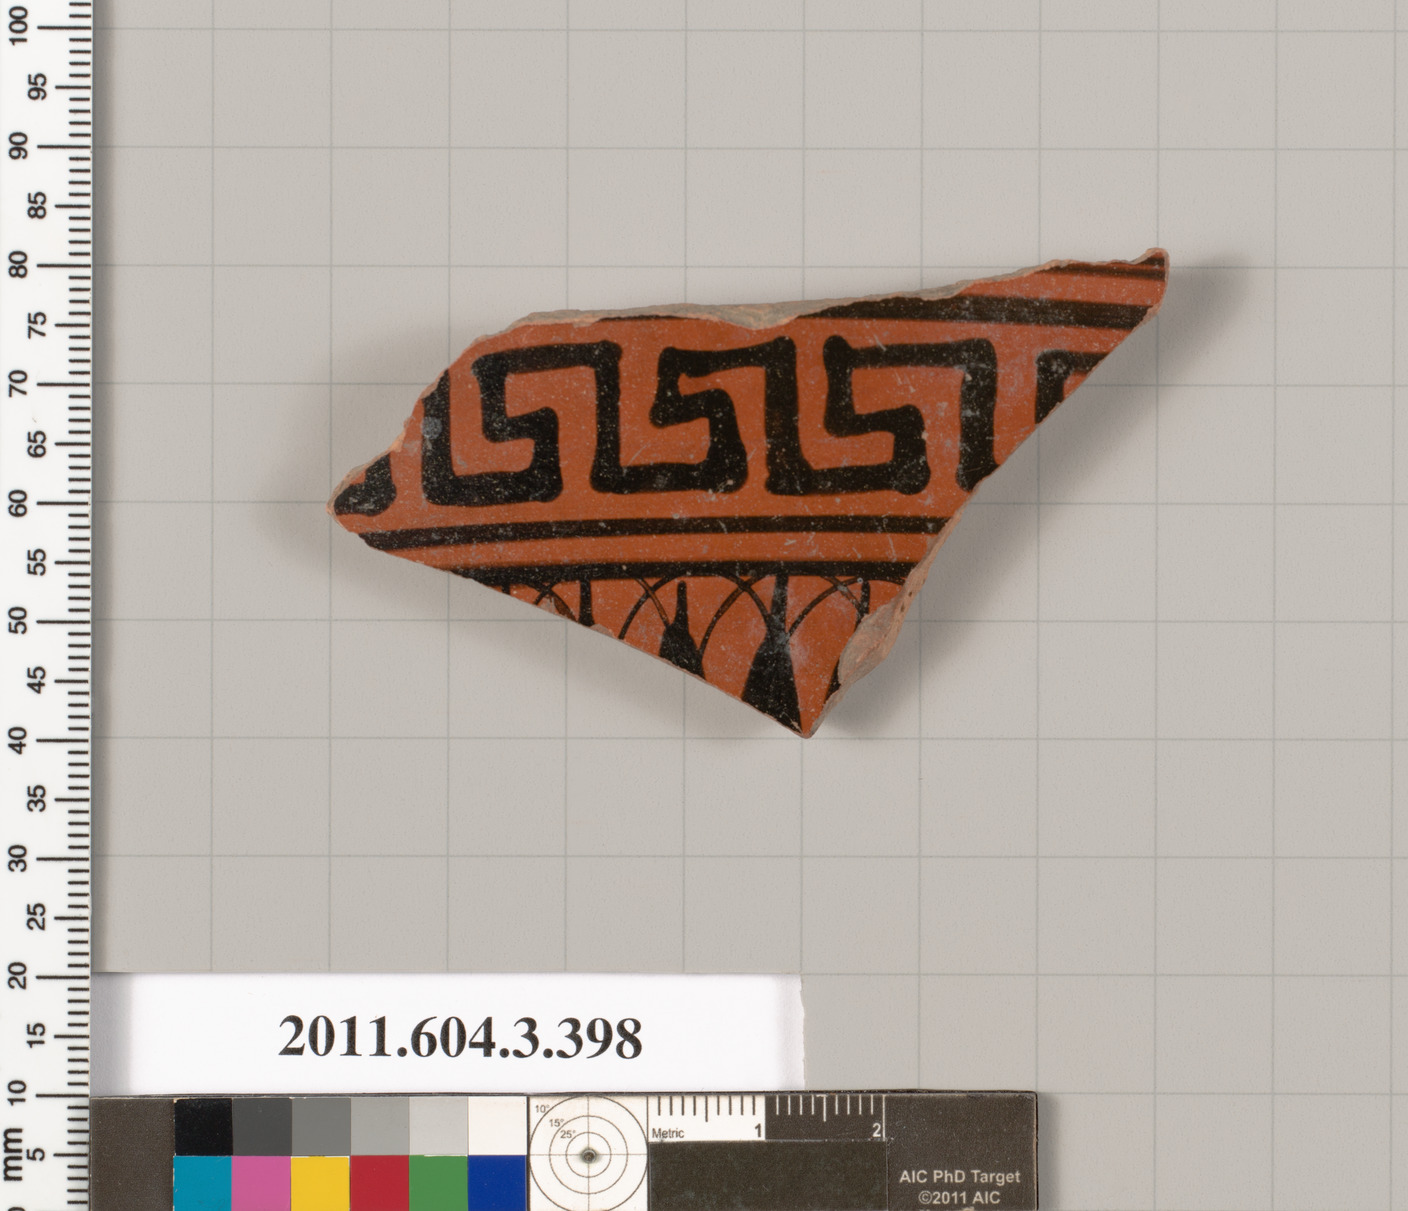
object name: neck amphora fragment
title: Terracotta fragment of a neck-amphora (jar)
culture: greek, attic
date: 500-468 BCE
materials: terracotta